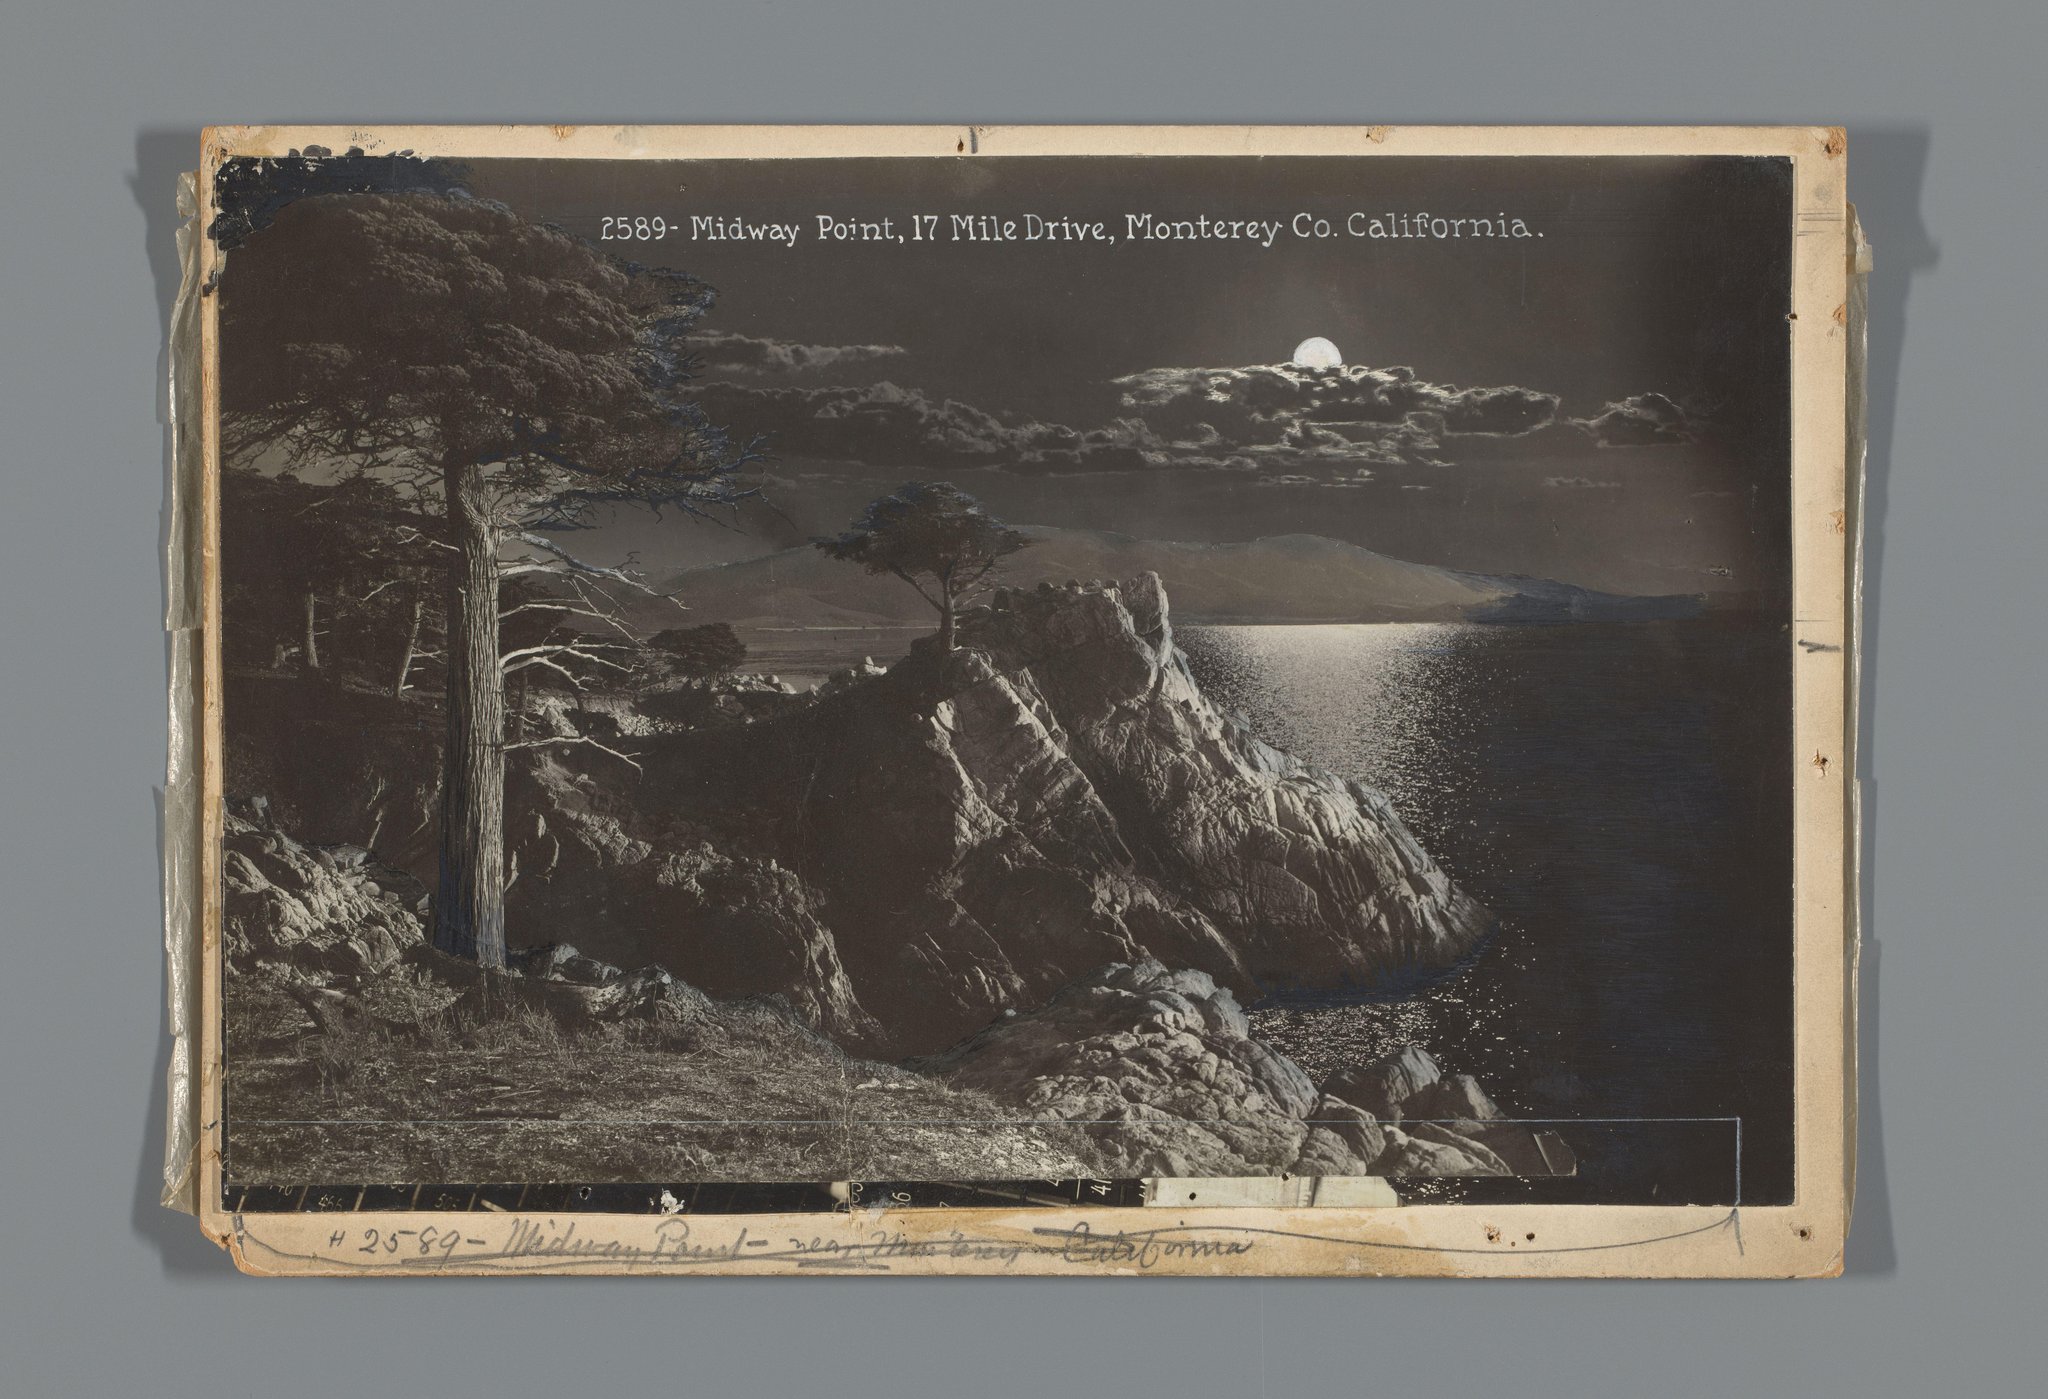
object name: photograph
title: Zicht op een meer en een oever bij Midway Point nabij Monterey, Californië bij nacht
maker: Anonymous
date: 1910-1930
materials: ink, paint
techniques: gelatin silver print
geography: united states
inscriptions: annotation: ‘2589- Midway Point, 17 Mile Drive, Monterey Co. California.’, annotation: ‘Souvenir Publishing Co. [doorgehaald] // PACIFIC NOVELTY CO. / OF SAN FRANCISCO’, annotation: ‘29/16 “ wide / 1 ¾ “ high / Leave off title at top’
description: Opgewerkte foto met in de marges aanwijzingen voor de opmaak.